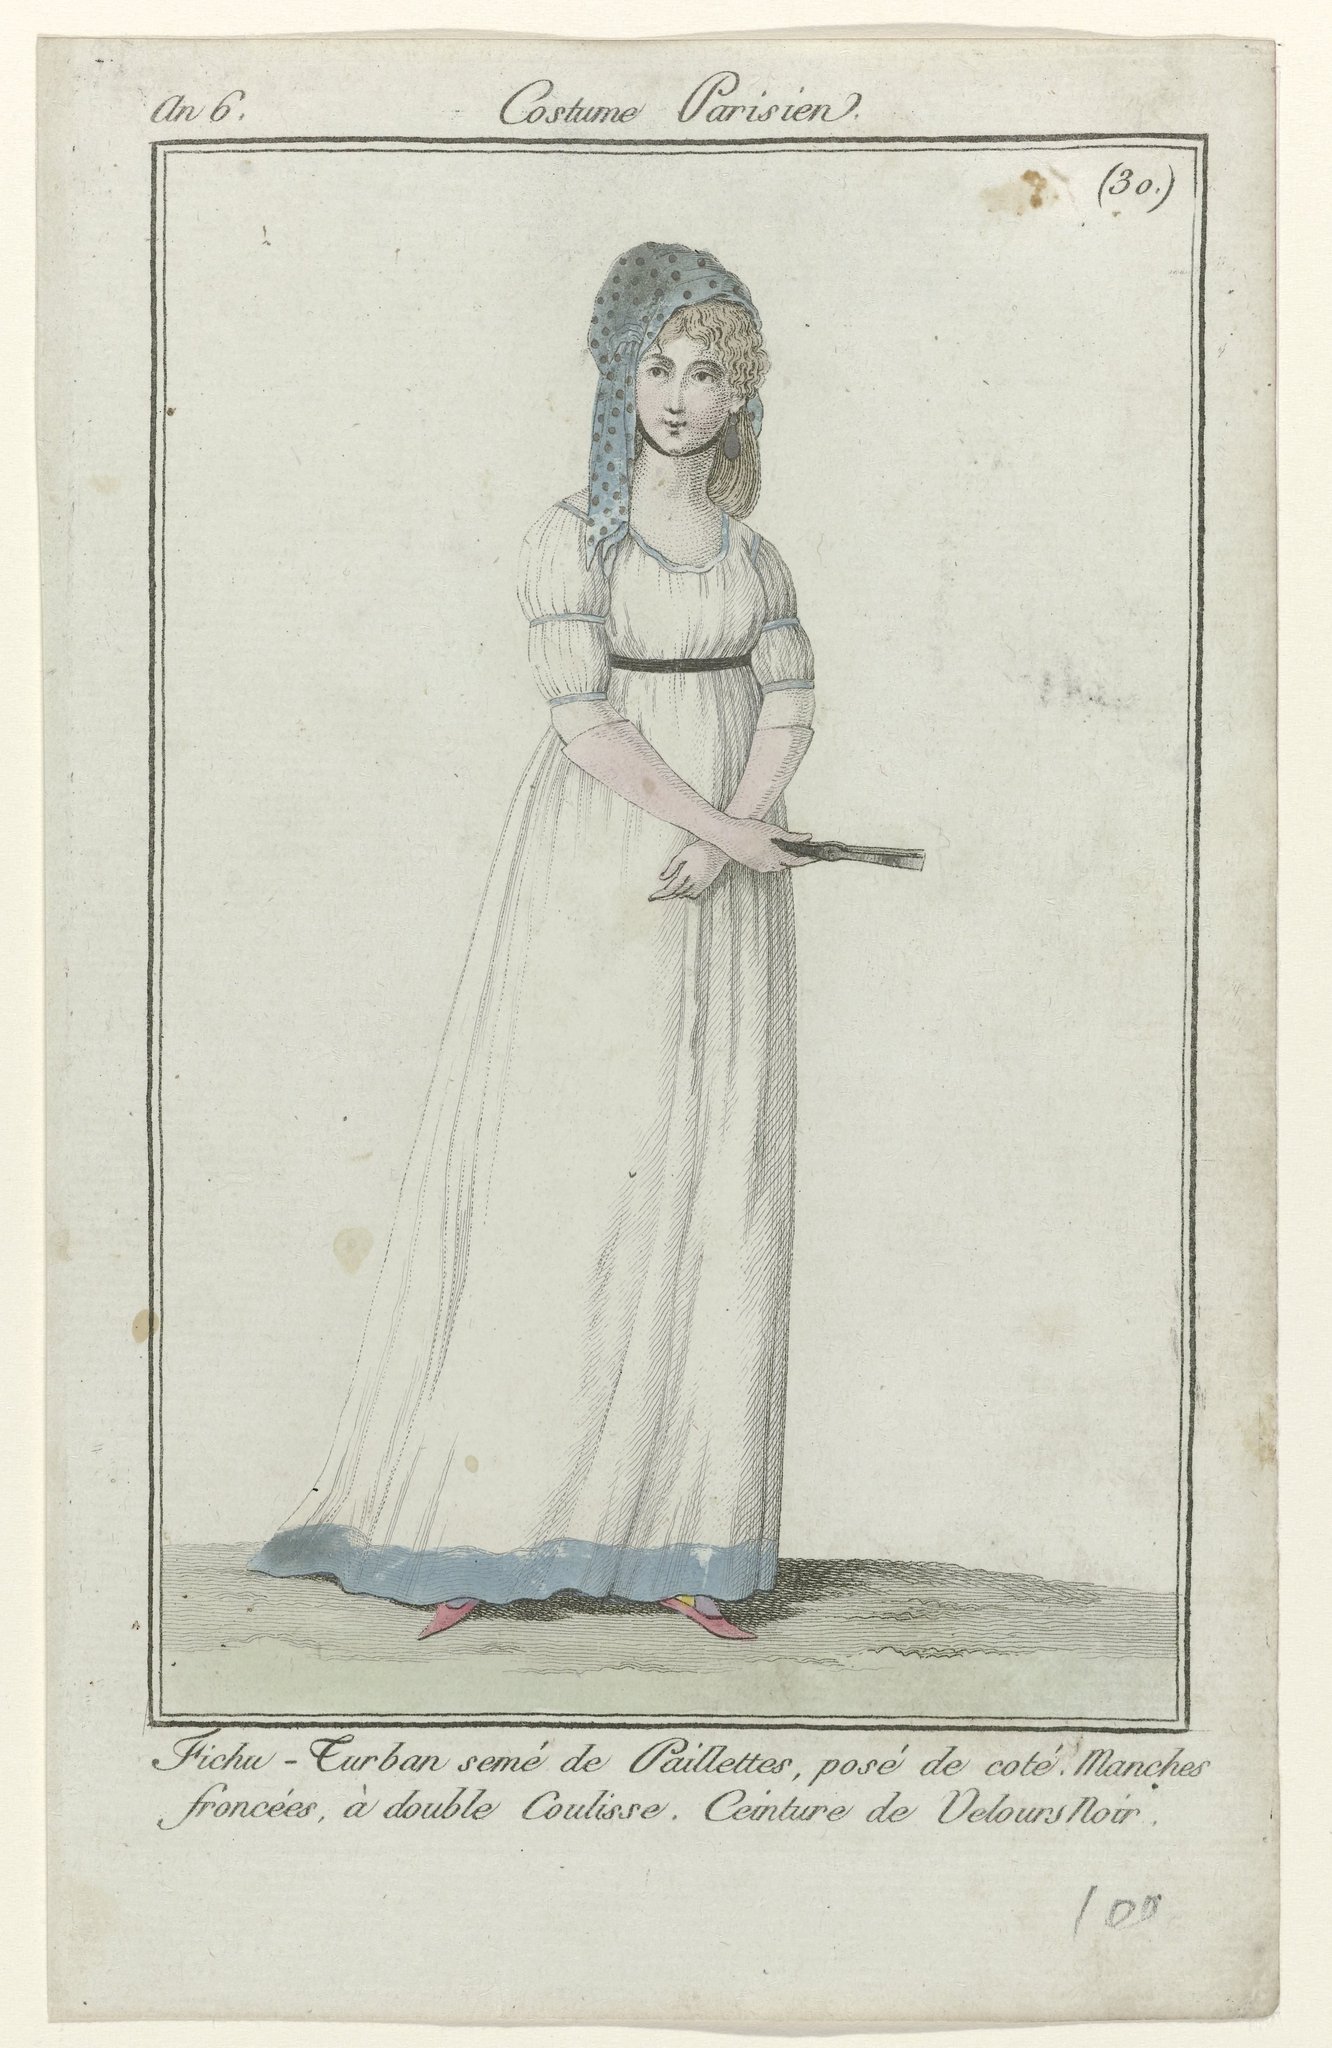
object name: fashion print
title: Journal des Dames et des Modes, Costume Parisien, 10 avril 1798, An 6 (30) : Fichu- Turban semé (...)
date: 1798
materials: paper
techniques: engraving, hand coloring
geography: paris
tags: head-gear: turban (+ women's clothes), gloves, mittens (long gloves) (+ women's clothes), border, ribbon, braid (+ women's clothes), fashion plates, shoes, sandals (+ women's clothes), dress, gown (+ women's clothes), fan (+ women's clothes), piece of clothing covering the breast or décolleté (fichu) (+ women's clothes), sleeves (+ women's clothes), belt, girdle, waistband (+ women's clothes)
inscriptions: title: ‘Costume Parisien.’, caption: ‘Fichu- Turban semé de Paillettes, posé de coté. Manches froncées, à double Coulisse. Ceinture de Velours Noir.’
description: Fichu-tulband, bezaaid met pailletten. Japon met gesmokte mouwen. Ceintuur van zwart fluweel. Verdere accessoires: oorbel in het linkeroor, lange handschoenen, waaier, platte schoenen met puntige neuzen. De prent maakt deel uit van het modetijdschrift Journal des Dames et des Modes, uitgegeven door Sellèque, Parijs, 1797-1839.